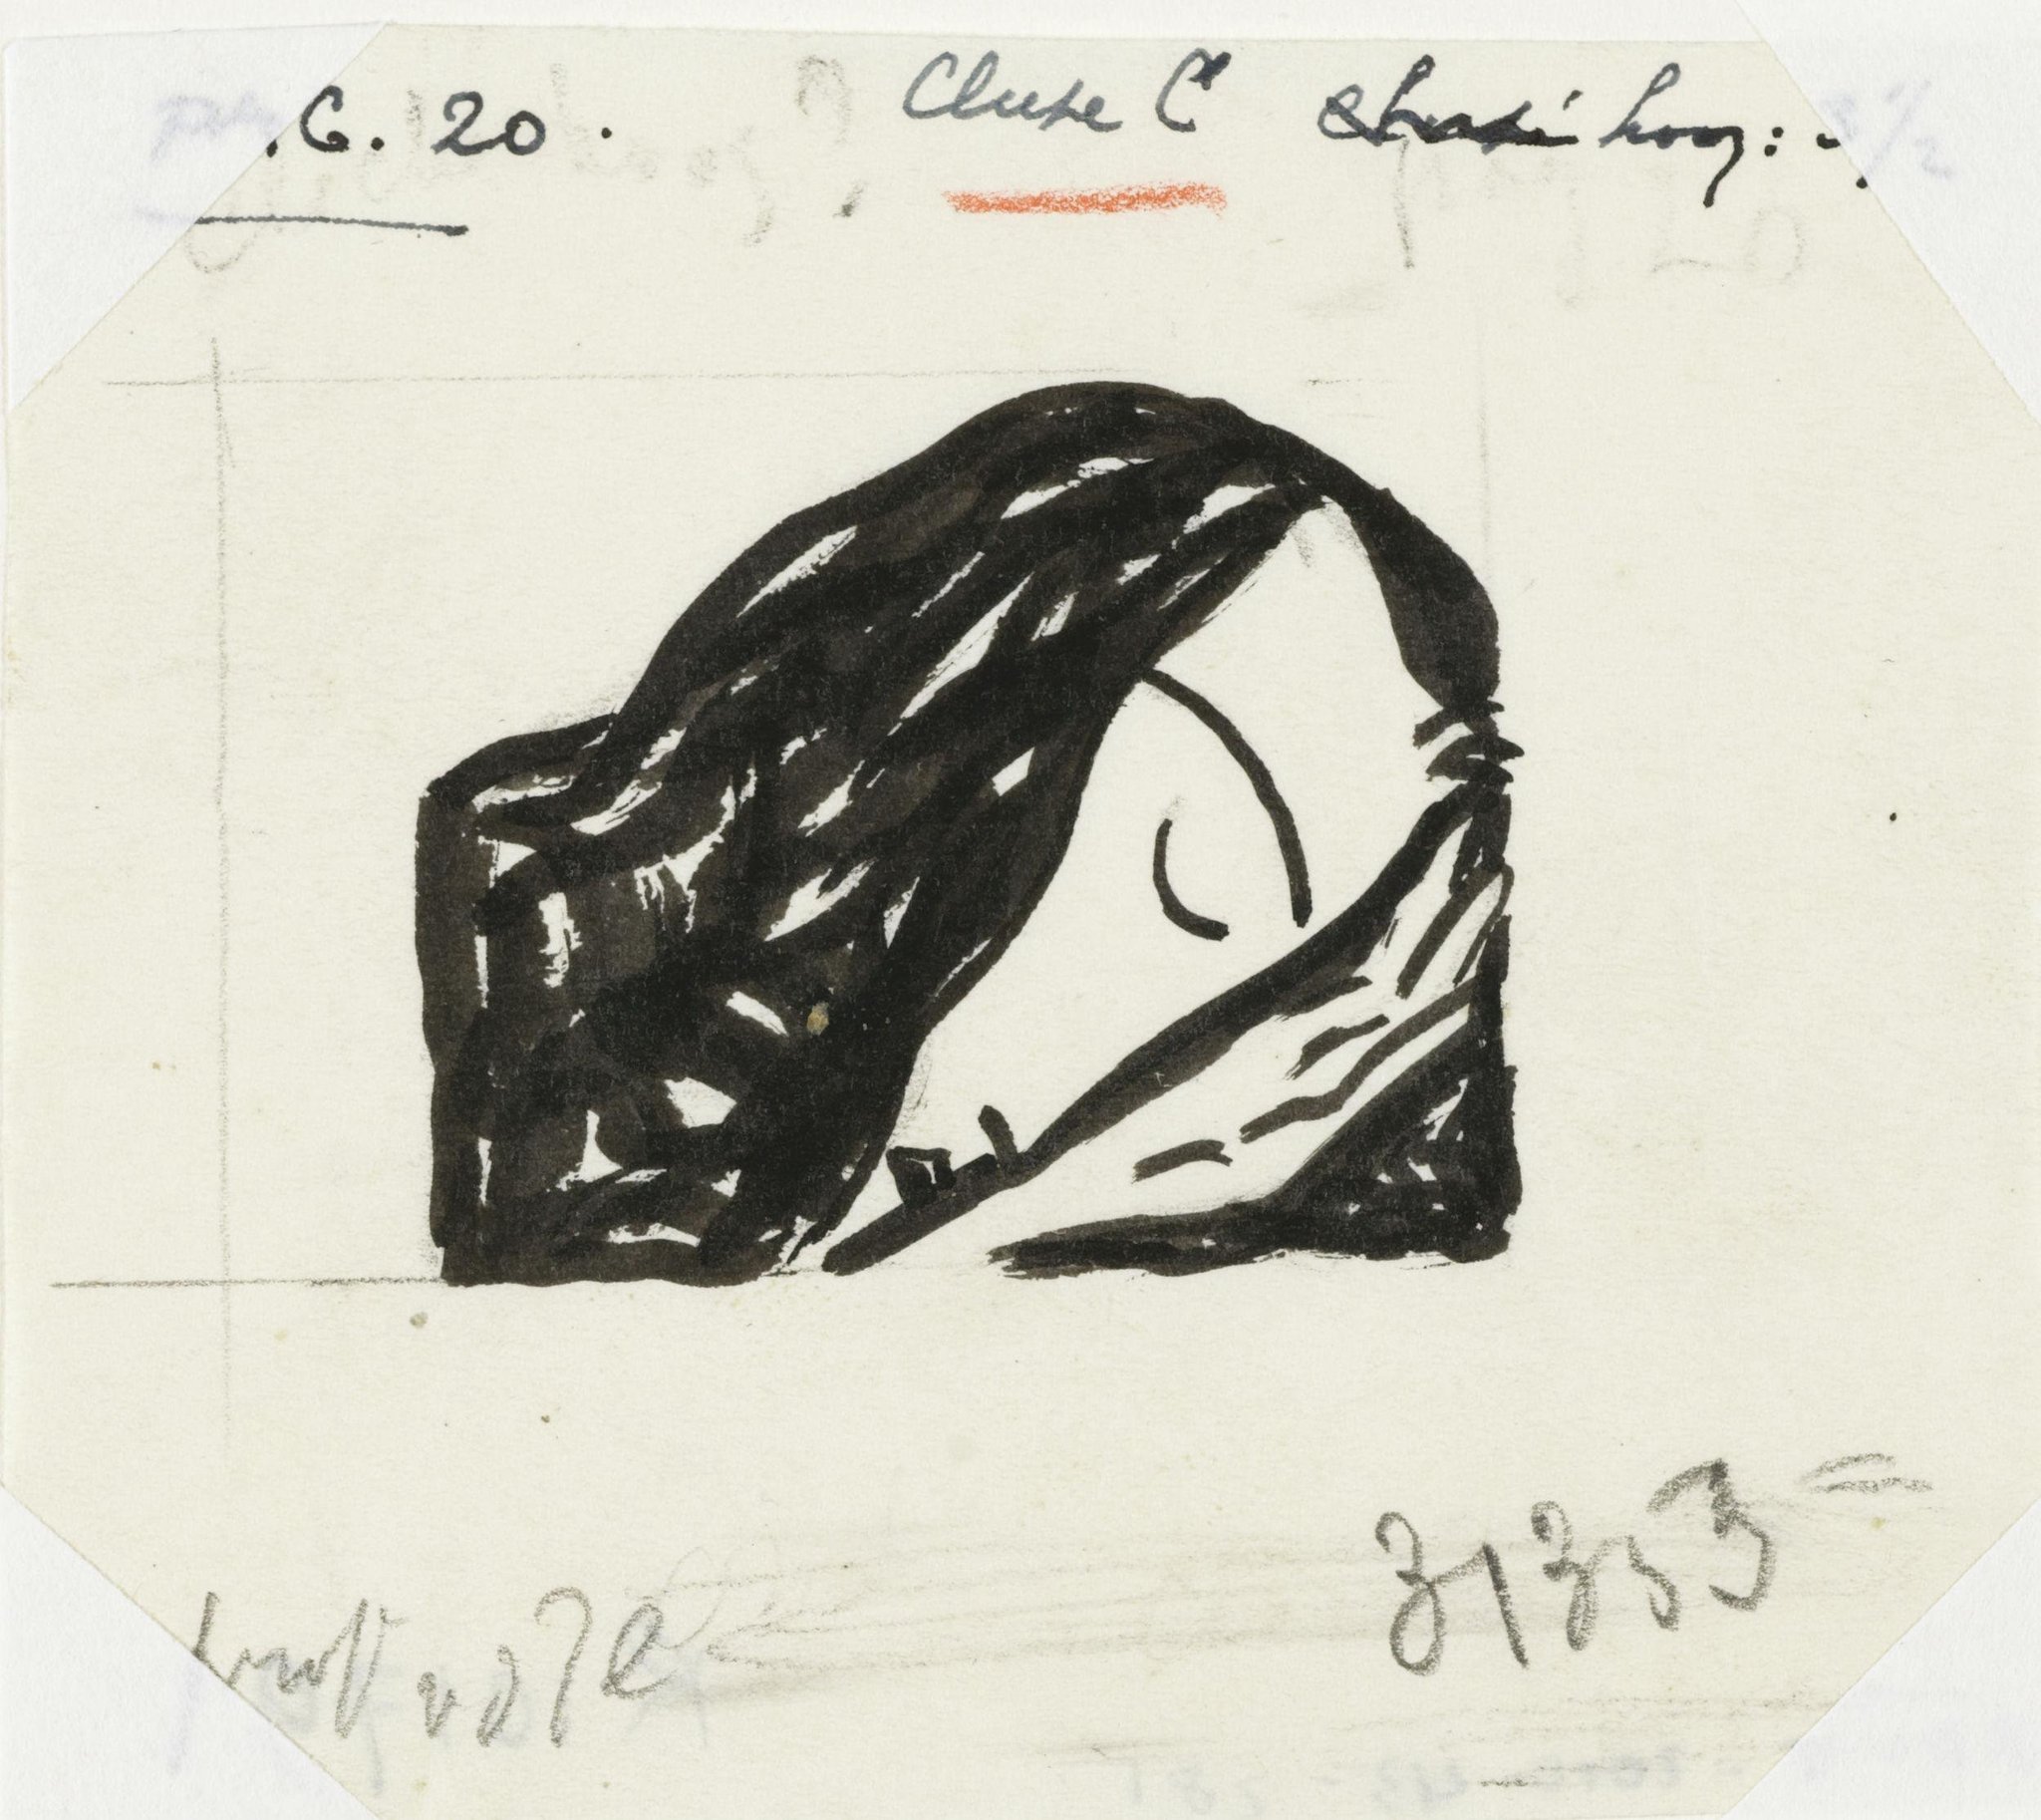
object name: drawing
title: Zonder titel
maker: leo gestel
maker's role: draughtsman, print maker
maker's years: 1881-1941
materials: ink, paper, pencil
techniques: brush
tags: head (human) - aa - female human figure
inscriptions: inscription: ‘prof. vd Pl’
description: Kop van vrouw met gesloten ogen en golvend donker haar, rustend op haar handpalm.